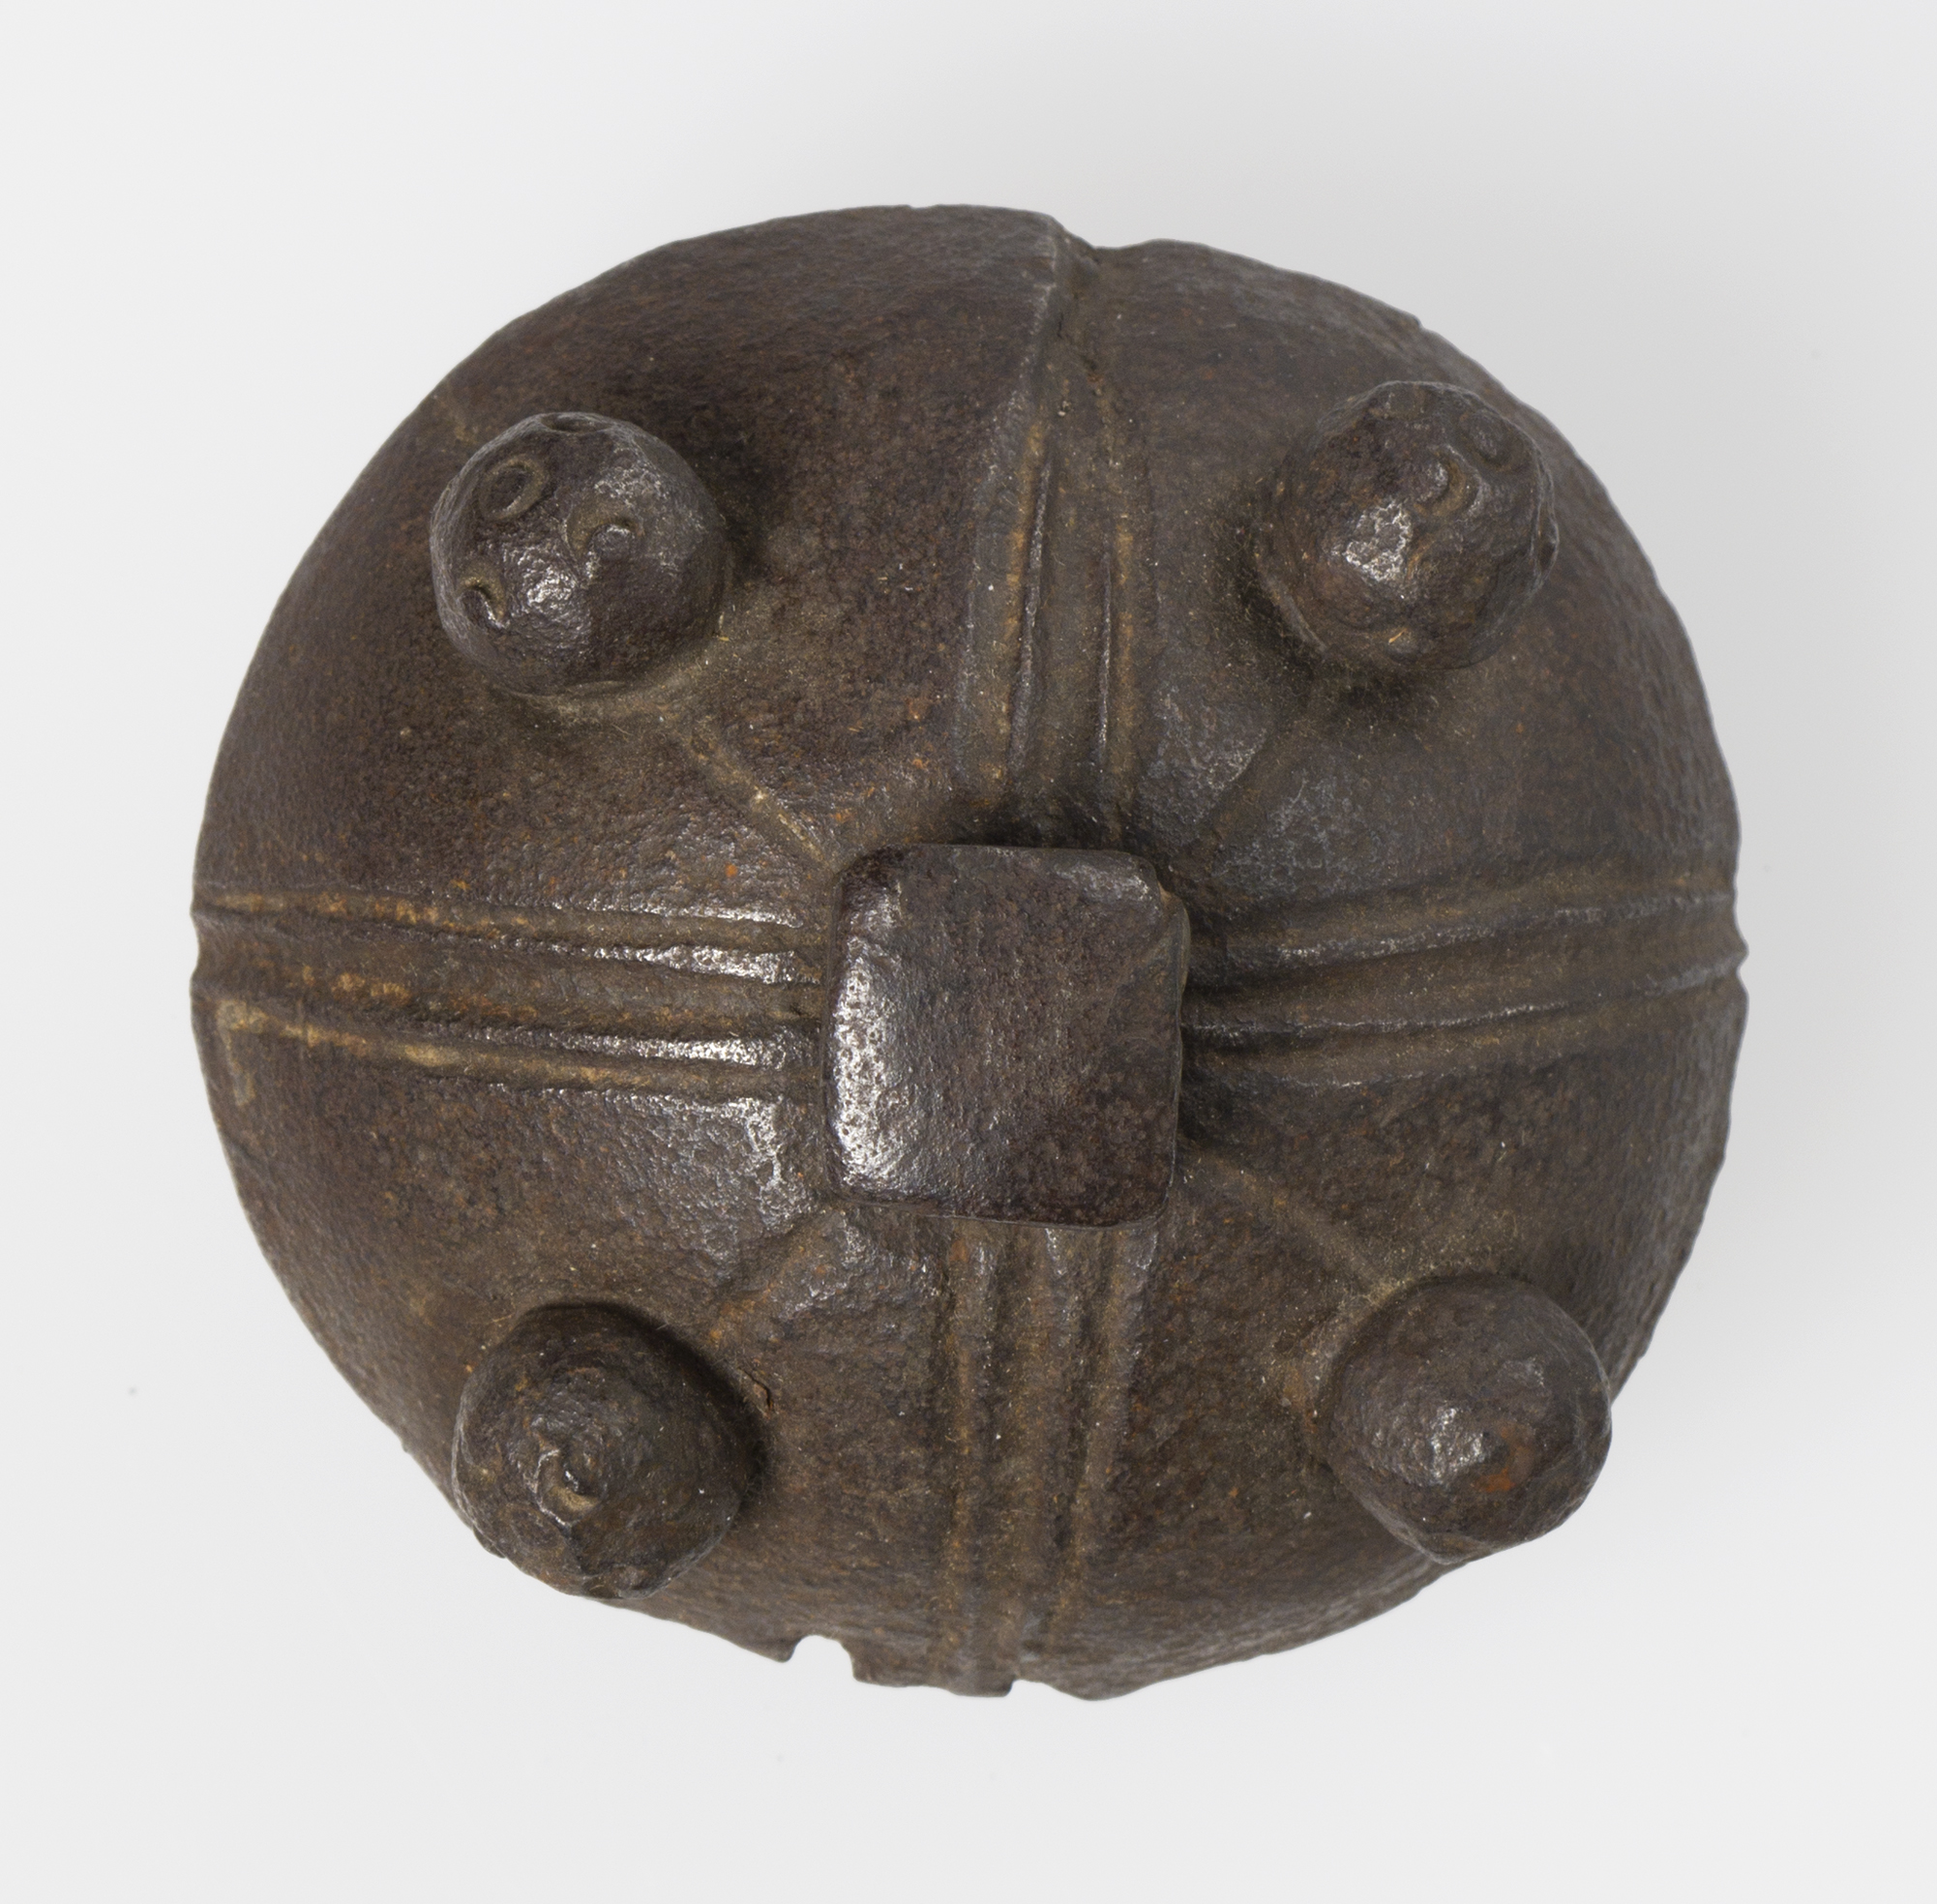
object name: bos and nail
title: Boss and Nail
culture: european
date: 1401-1600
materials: iron